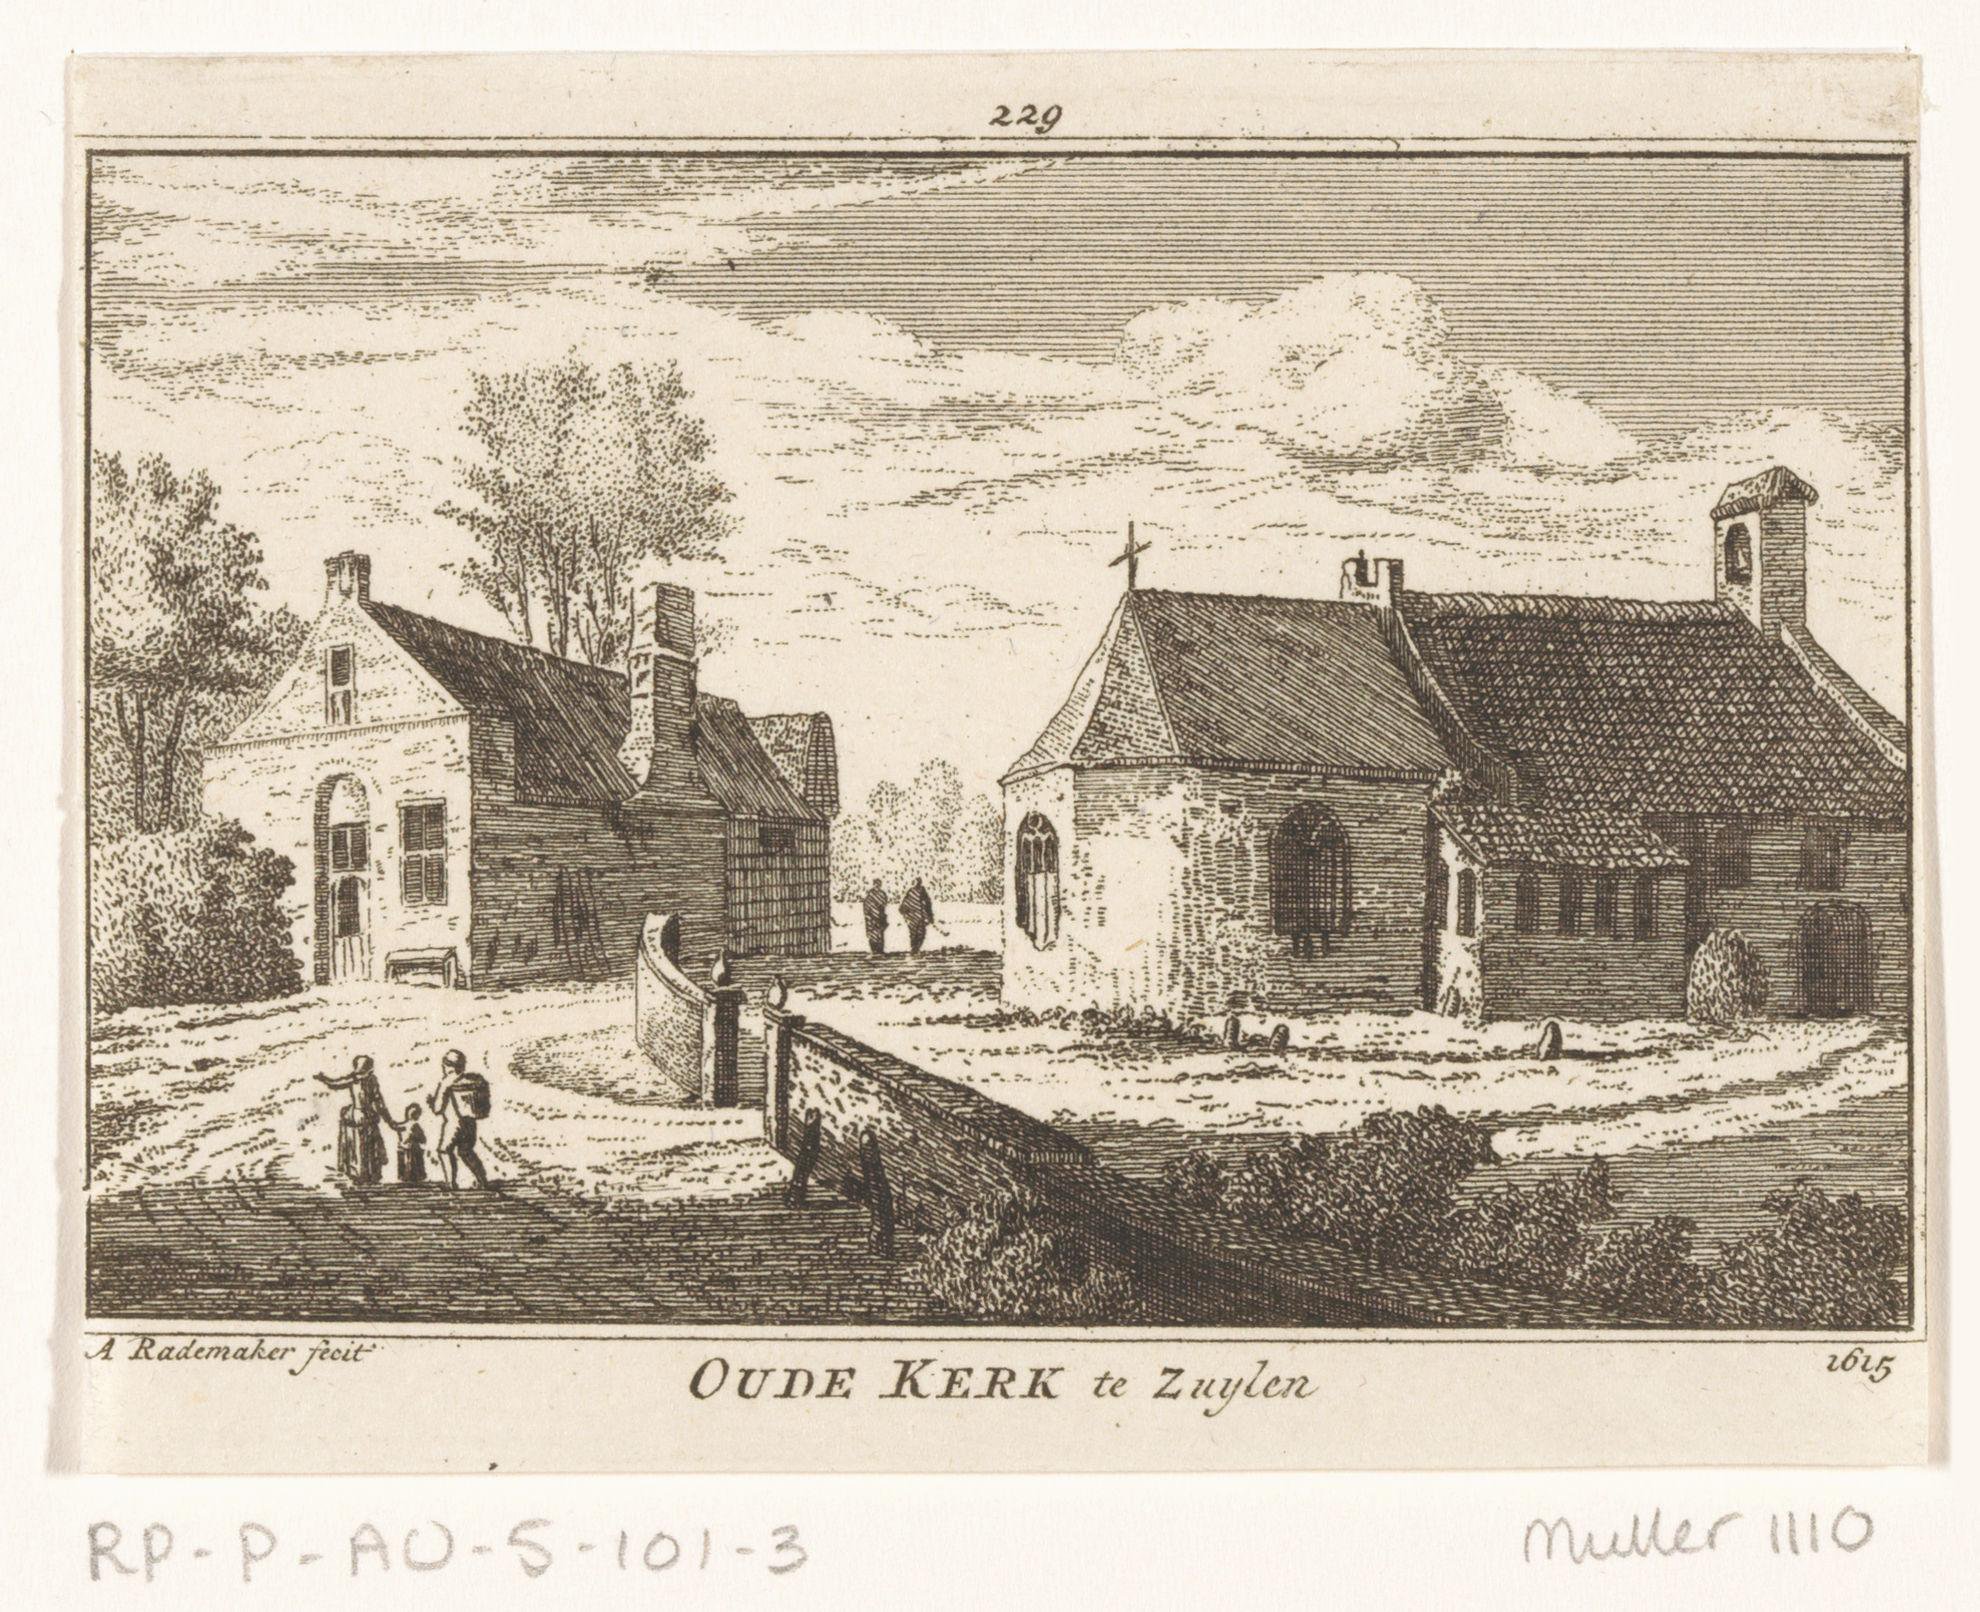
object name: book illustration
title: Het huis Lievendaal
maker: hendrik spilman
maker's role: draughtsman, painter, print maker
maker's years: 1721-1784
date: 1773-1792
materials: paper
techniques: engraving, etching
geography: haarlem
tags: castle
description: Prent ook gebruikt in: Het verheerlykt Nederland of kabinet van hedendaagsche gezigten van steden, dorpen (…). 9 delen. Amsterdam: Isaak Tirion en weduwe Isaak Tirion, 1745-1774, dl. 7, 8 of 9 (weduwe Isaak Tirion, 1773-1774), ill. 239. Of in: Nederlandsche tafereelen; of eene keurige verzameling van negen honderd fraaije gezigten van steden, dorpen, sloten, oudheden (….). 9 delen. Amsterdam: Jan de Groot, 1792, dl. 7, 8 of 9, ill. 239. Uit welke druk het huidige exemplaar precies komt is niet na te gaan.